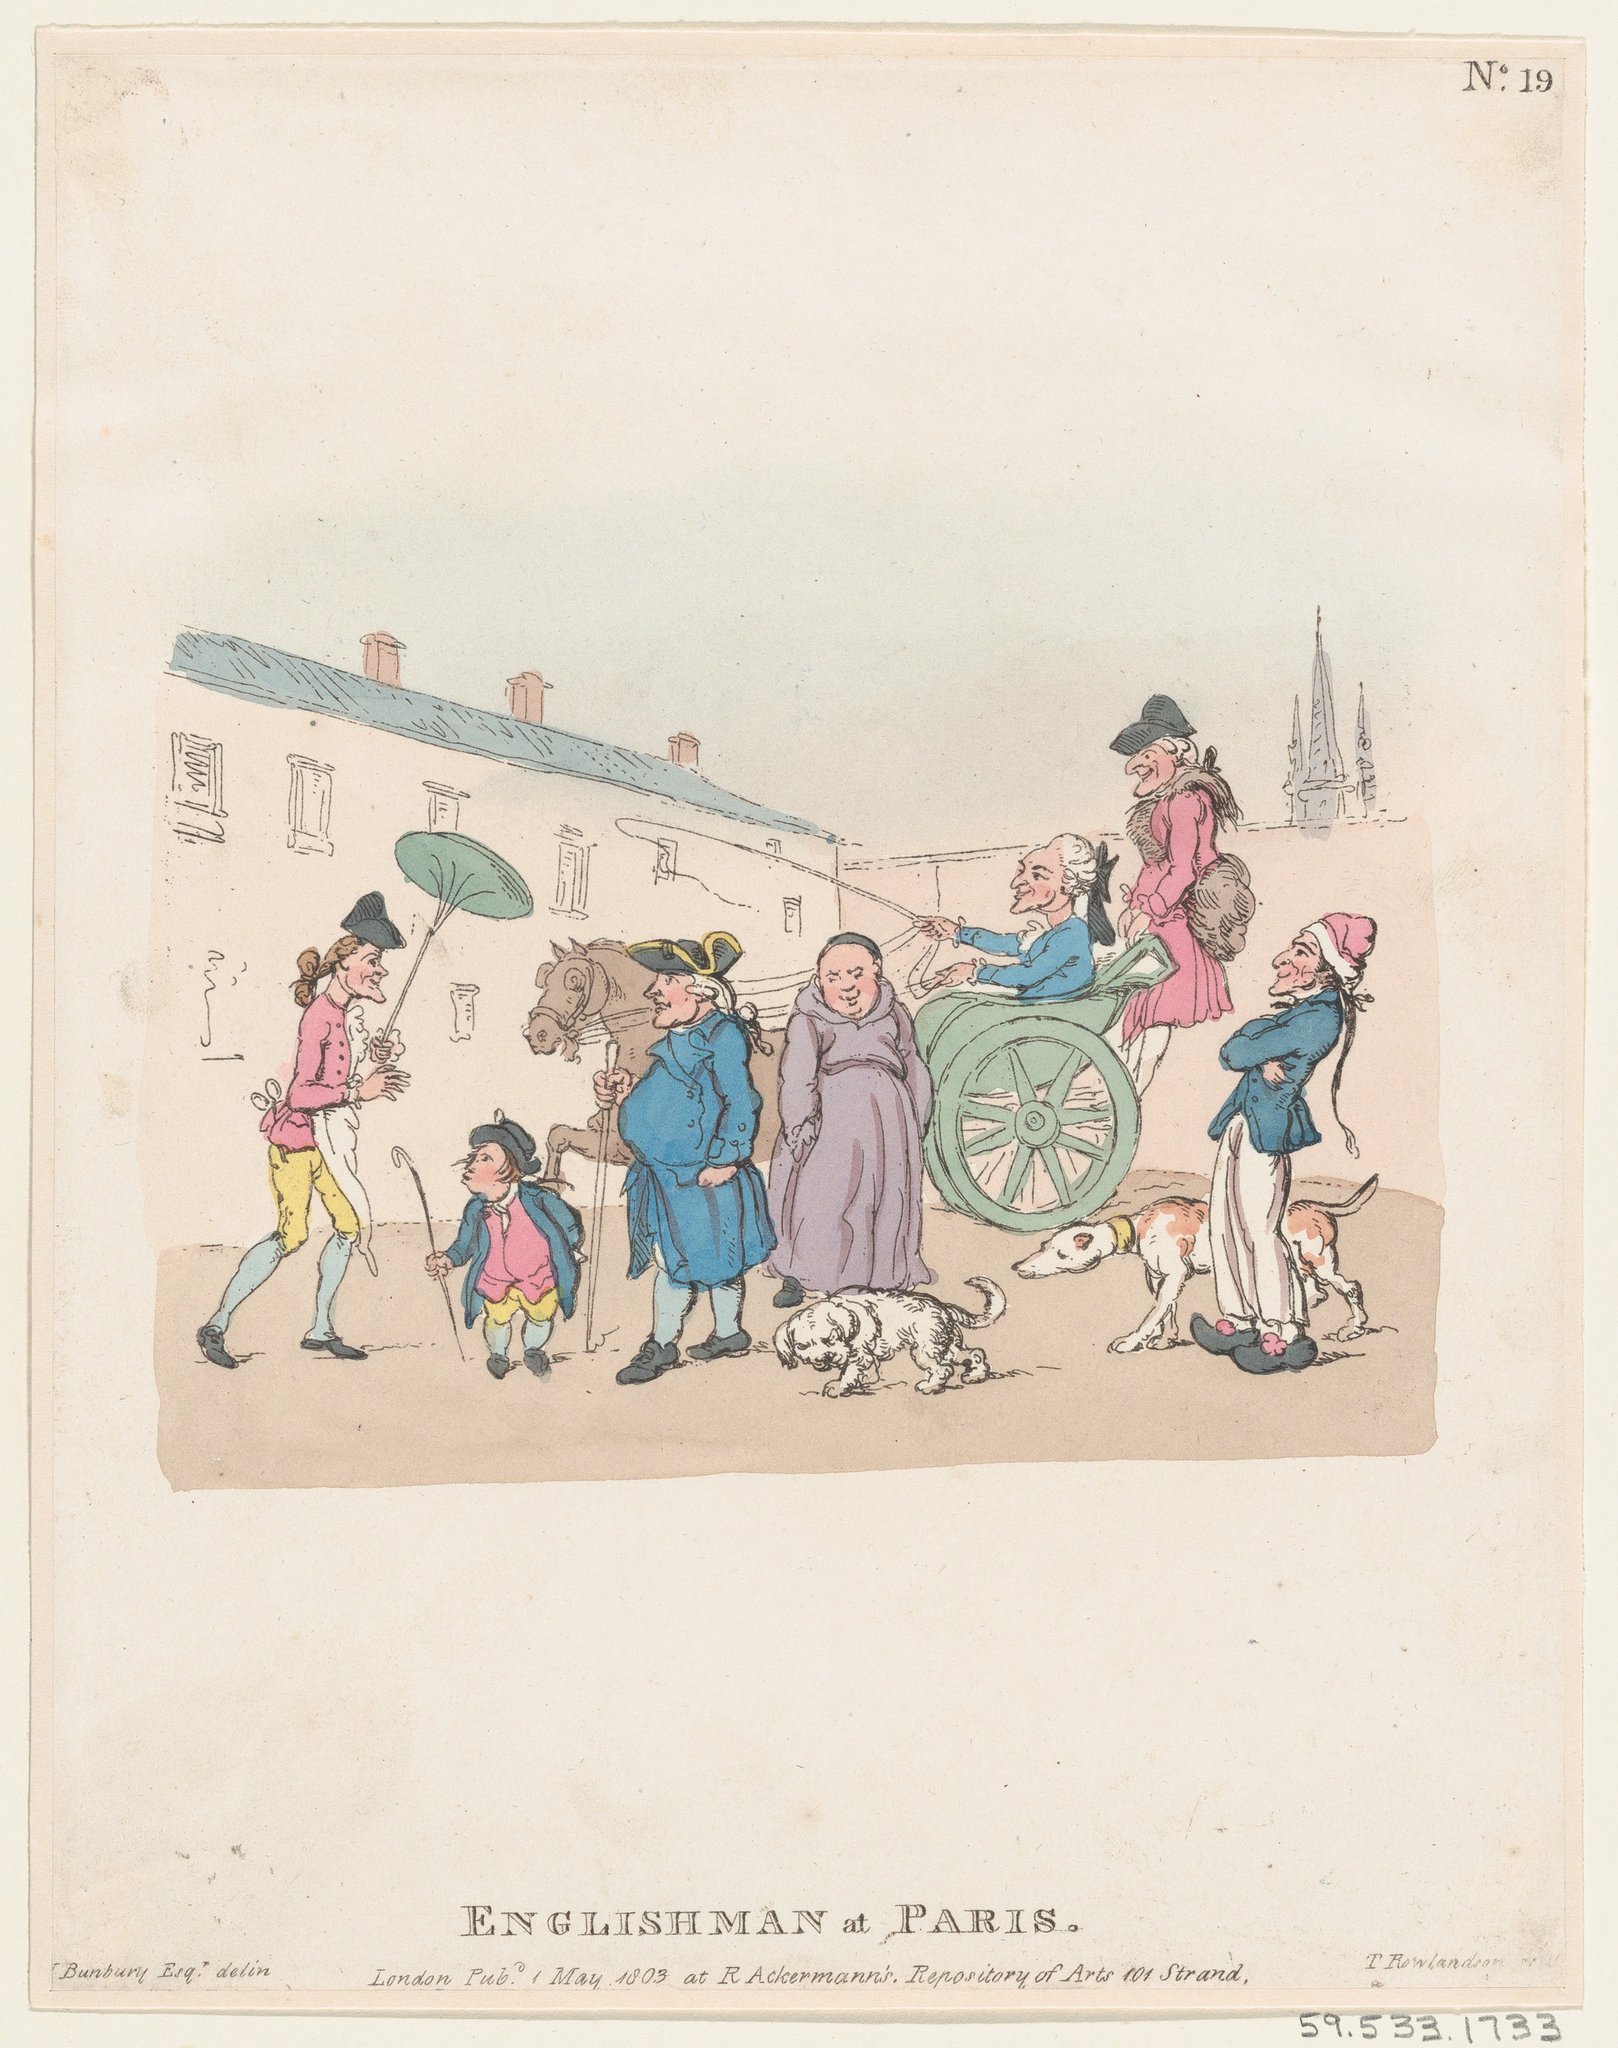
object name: print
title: Englishman at Paris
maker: thomas rowlandson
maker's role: artist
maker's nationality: british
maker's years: 1757-1827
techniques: etching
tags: satire,men,dogs,carriages